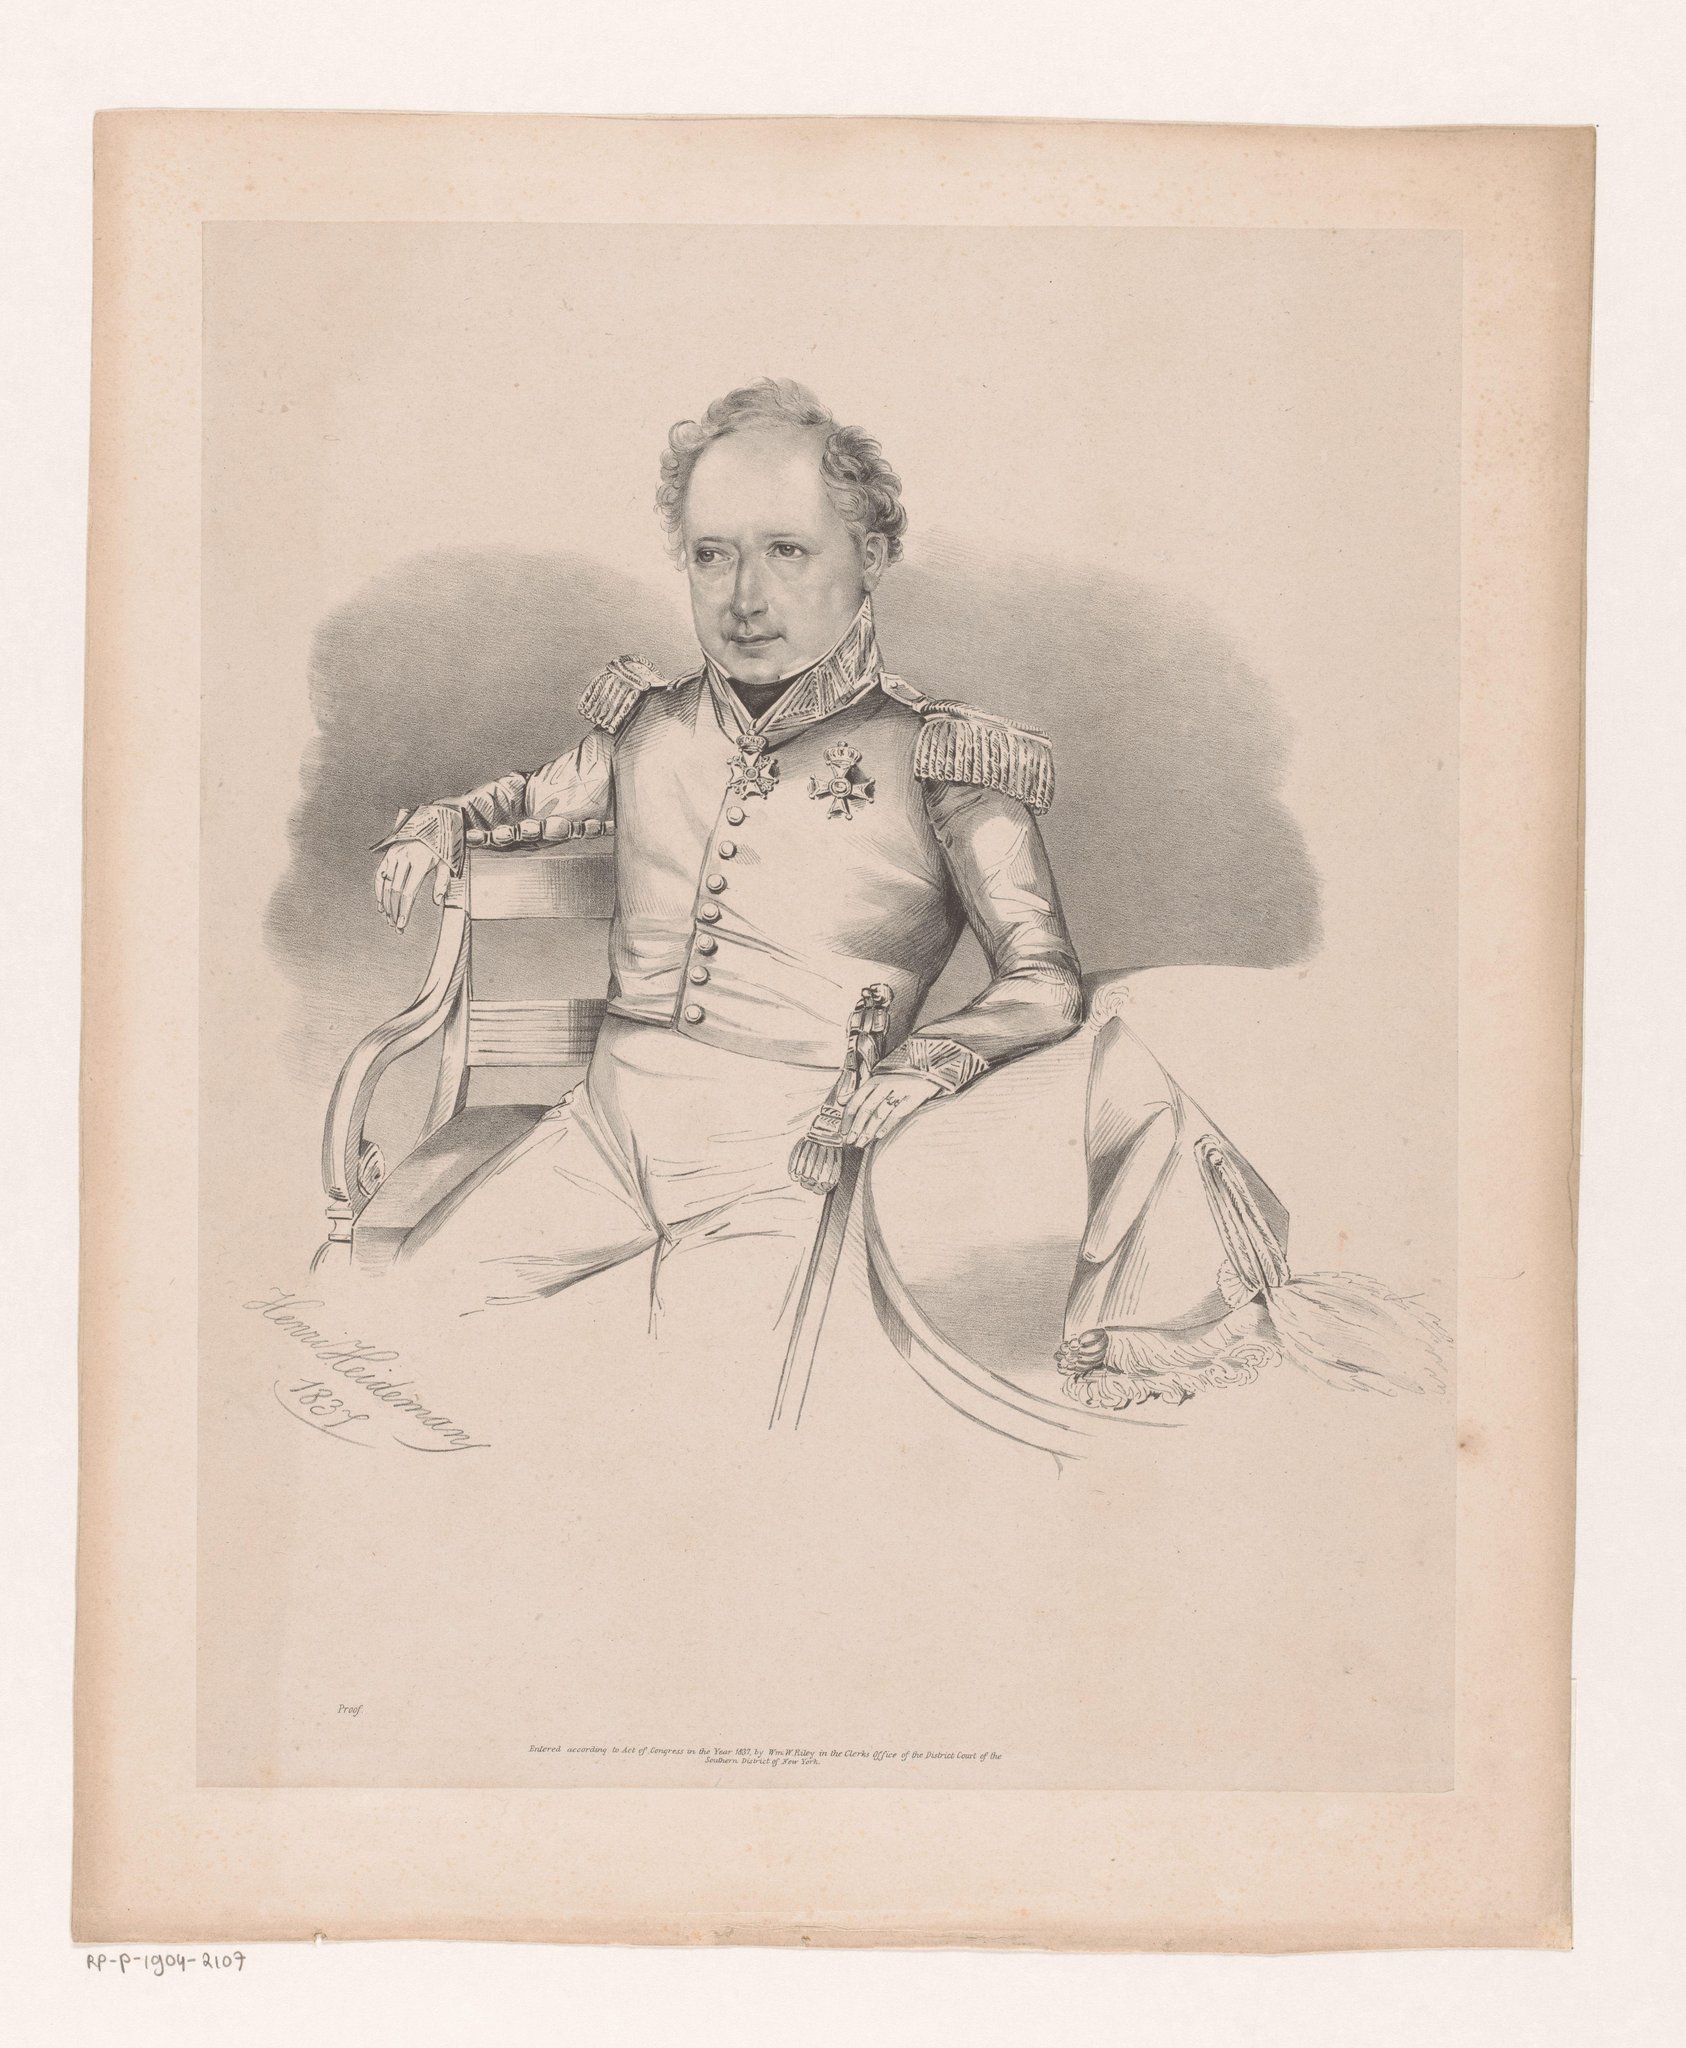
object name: print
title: Portret van Evert Ludolf van Heeckeren van Waliën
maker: henri philippe heidemans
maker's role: print maker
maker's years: 1804-1864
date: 1837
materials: paper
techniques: lithograph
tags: hacking and thrusting weapons (with name), historical persons (+ three-quarter length portrait)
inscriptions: collector's mark: Lugt 2228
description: De geportretteerde zit naast een tafel. Hij draagt een militair kostuum en heeft een sabel in zijn linkerhand. Op de tafel ligt een hoofddeksel. De armen zijn opvallend kort weergegeven.